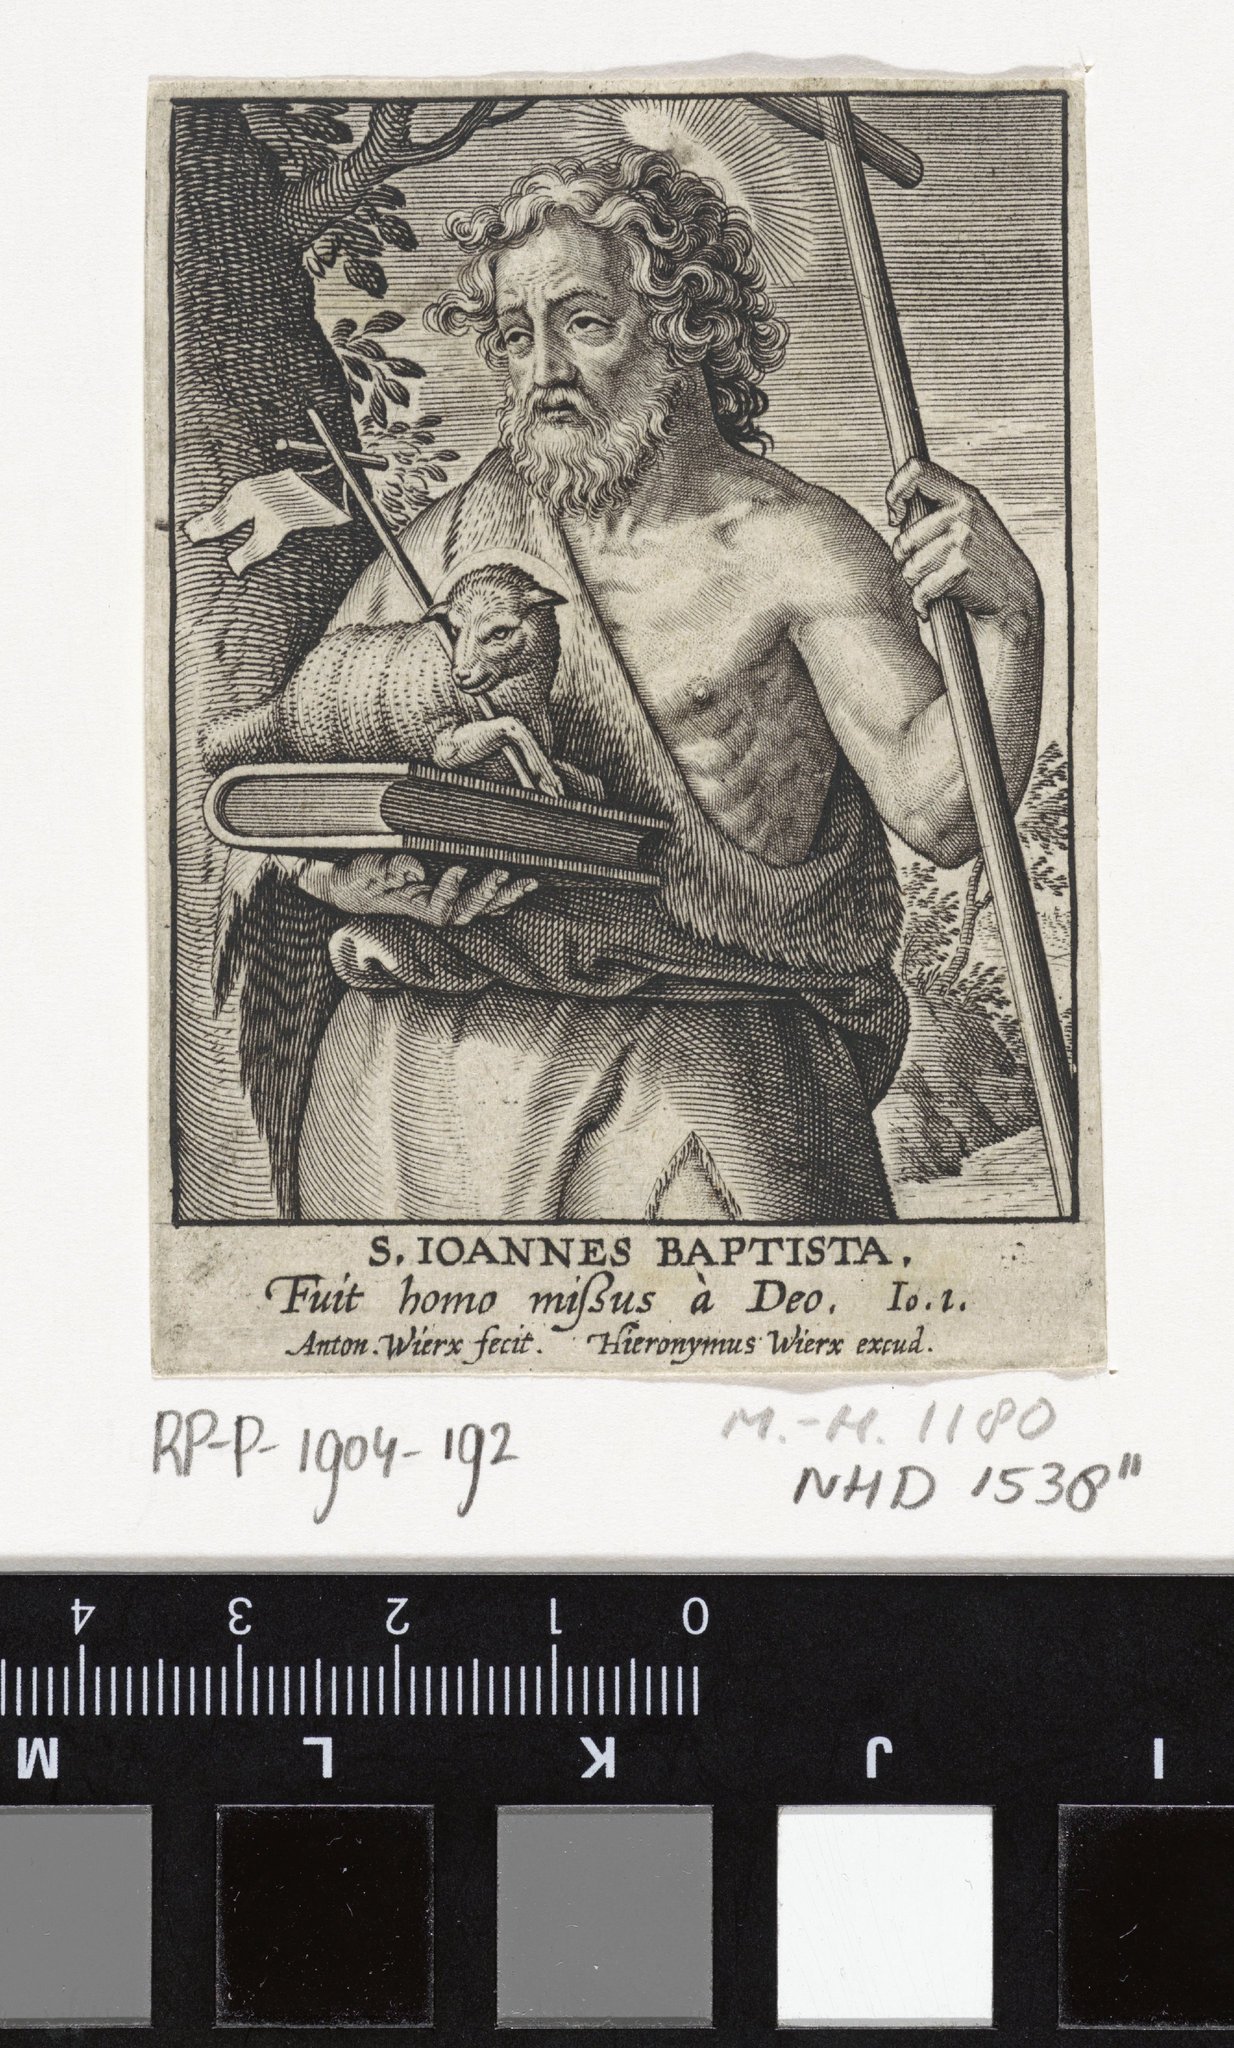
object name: print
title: Johannes de Doper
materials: paper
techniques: engraving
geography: antwerp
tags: john the baptist; possible attributes: book, reed cross, baptismal cup, honeycomb, lamb, staff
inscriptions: collector's mark: Lugt 2228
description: Johannes de Doper bij een boom. In zijn ene hand houdt hij de kruisstaf, in zijn andere hand de Bijbel met het Lam erop. In de marge een Bijbelcitaat uit Joh. 1 in het Latijn.